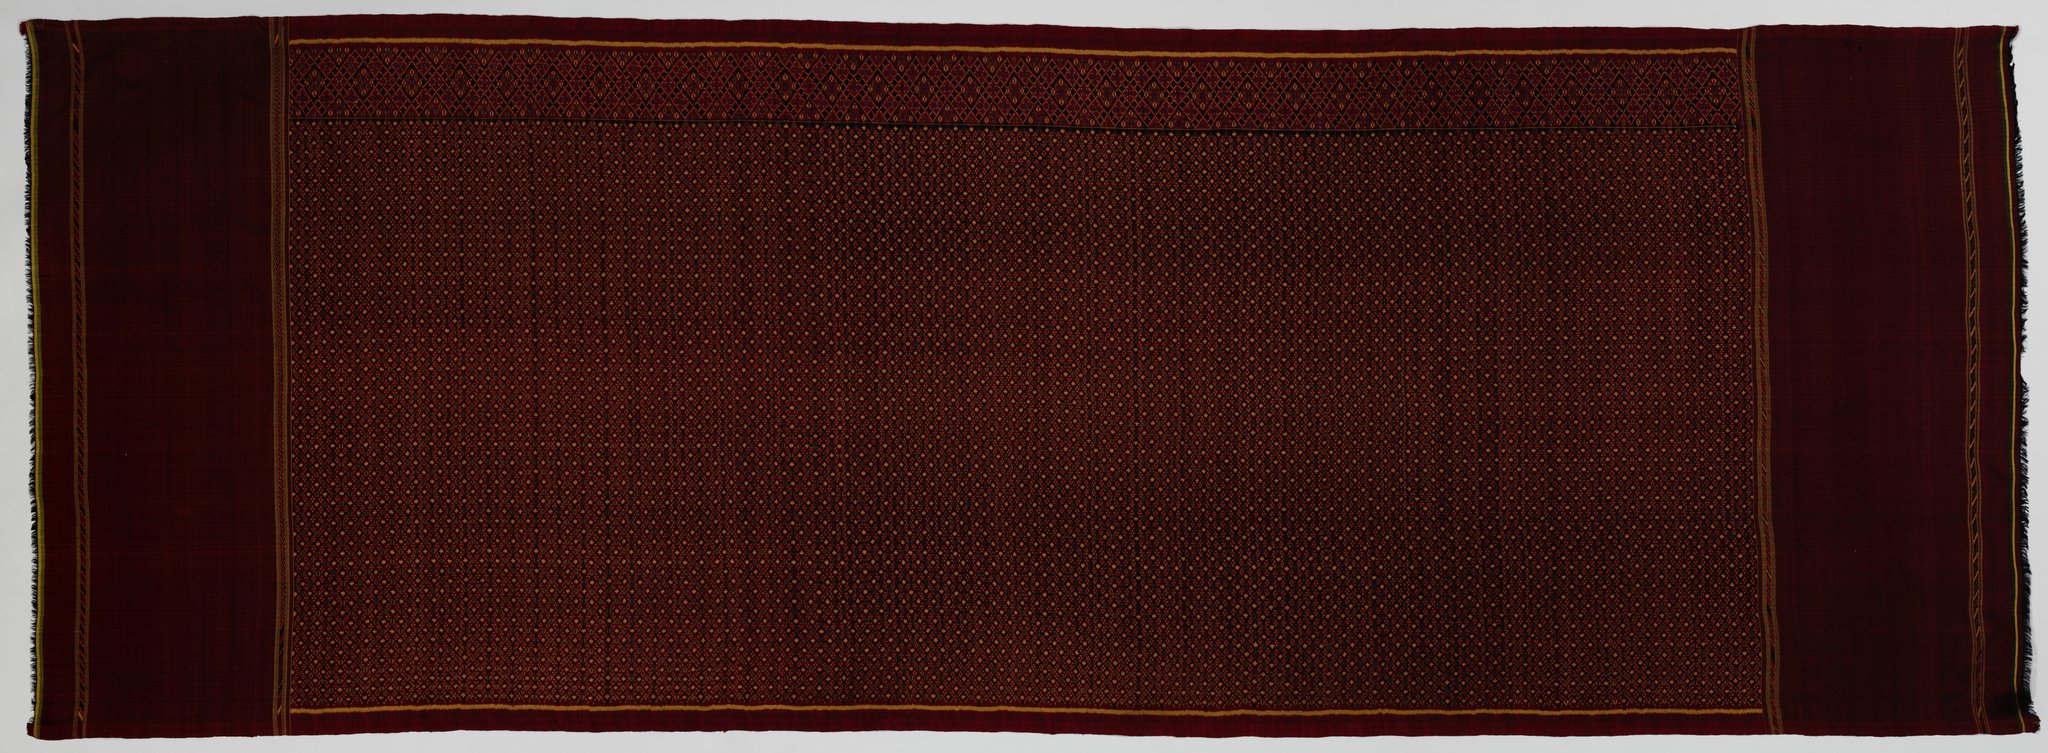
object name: heupdoek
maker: Anonymous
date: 1902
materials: silk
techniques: weave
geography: cambodia